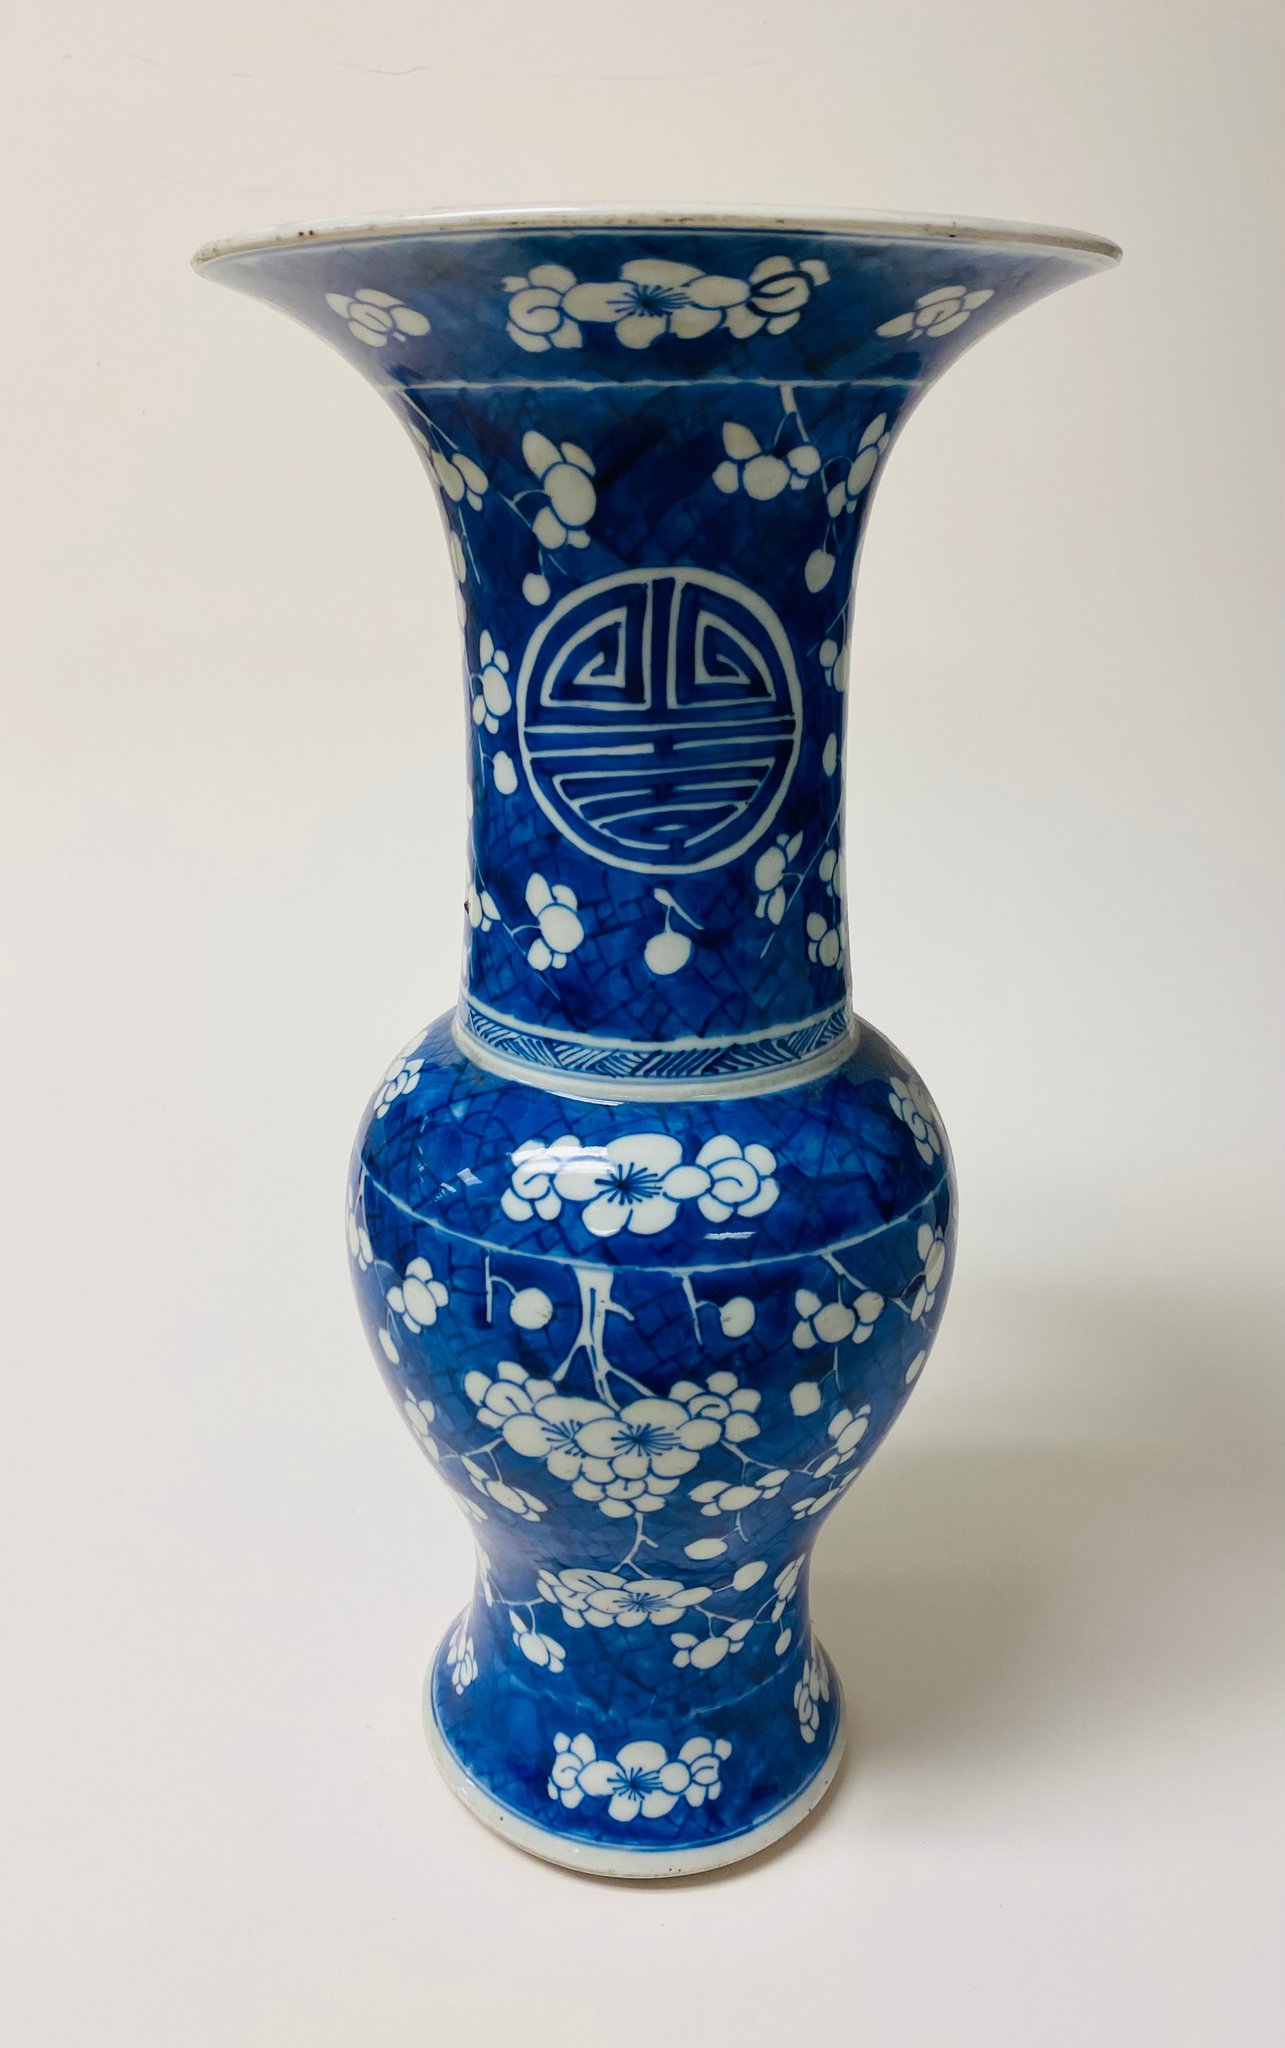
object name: vase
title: Vase with plum blossoms (one of a pair)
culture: chinese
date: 1667-1733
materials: cobalt, porcelain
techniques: painting, underglaze